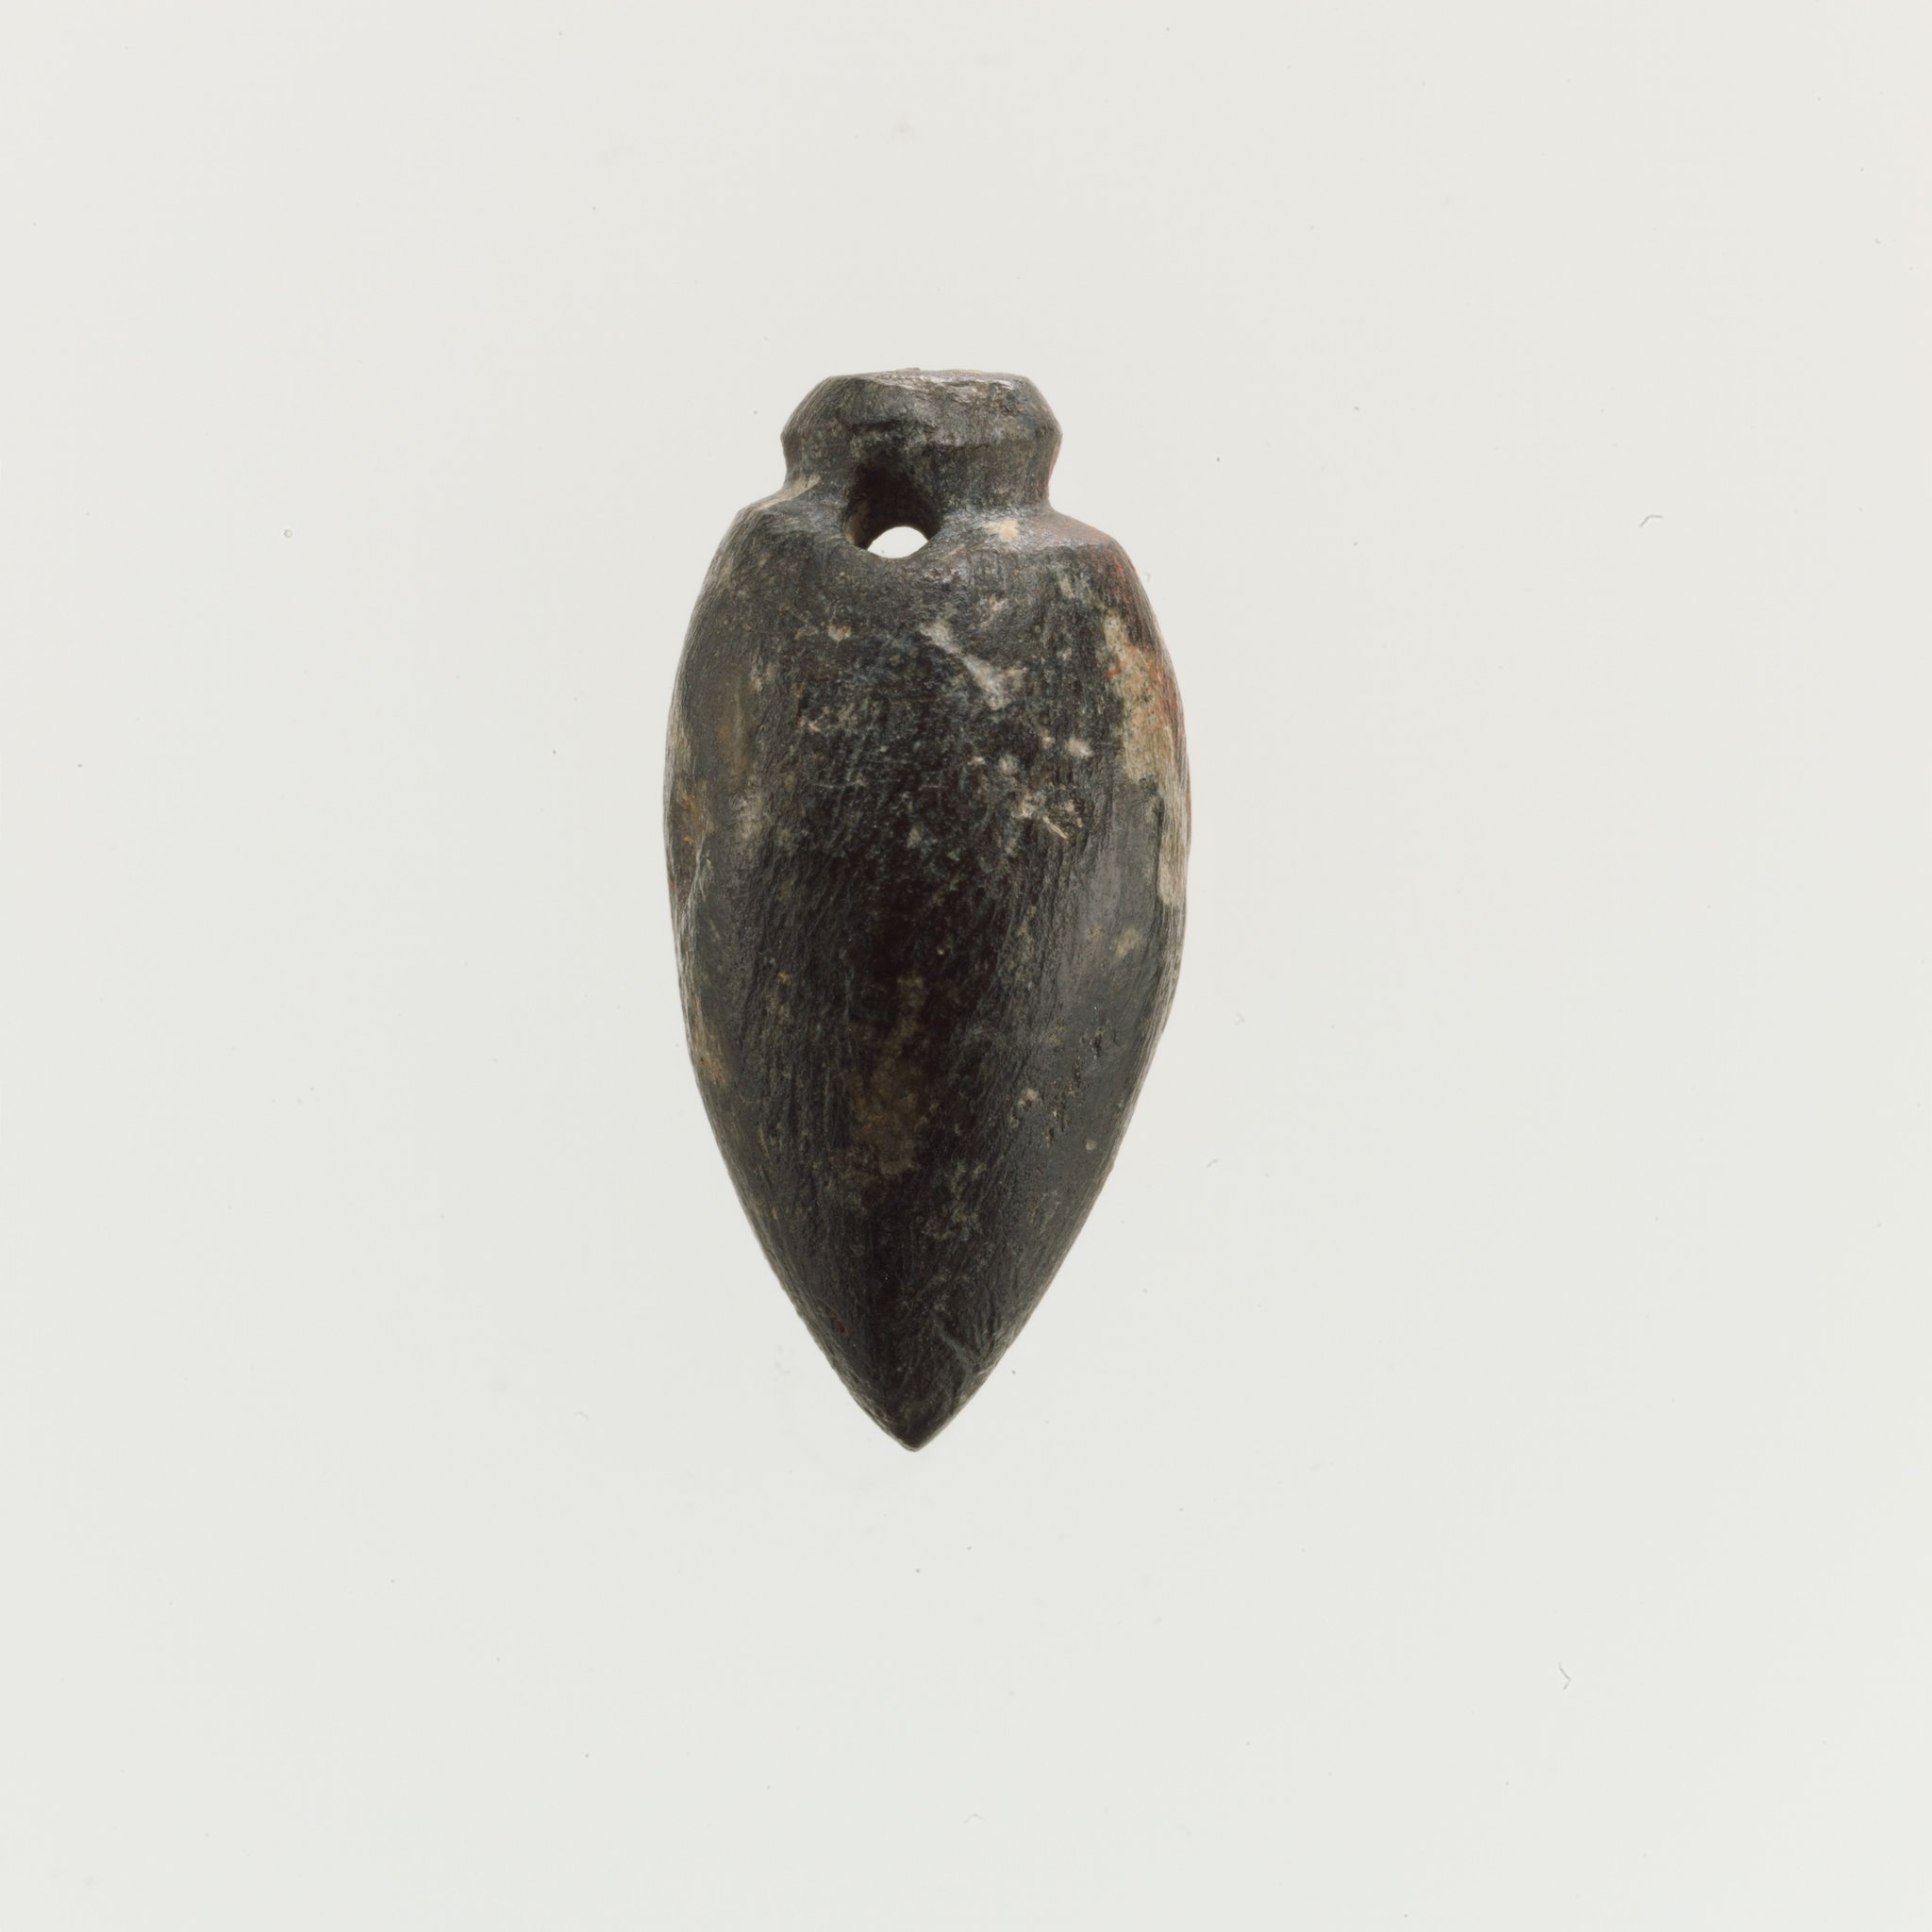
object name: pendant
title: Steatite pendant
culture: minoan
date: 3000-1668 BCE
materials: stone